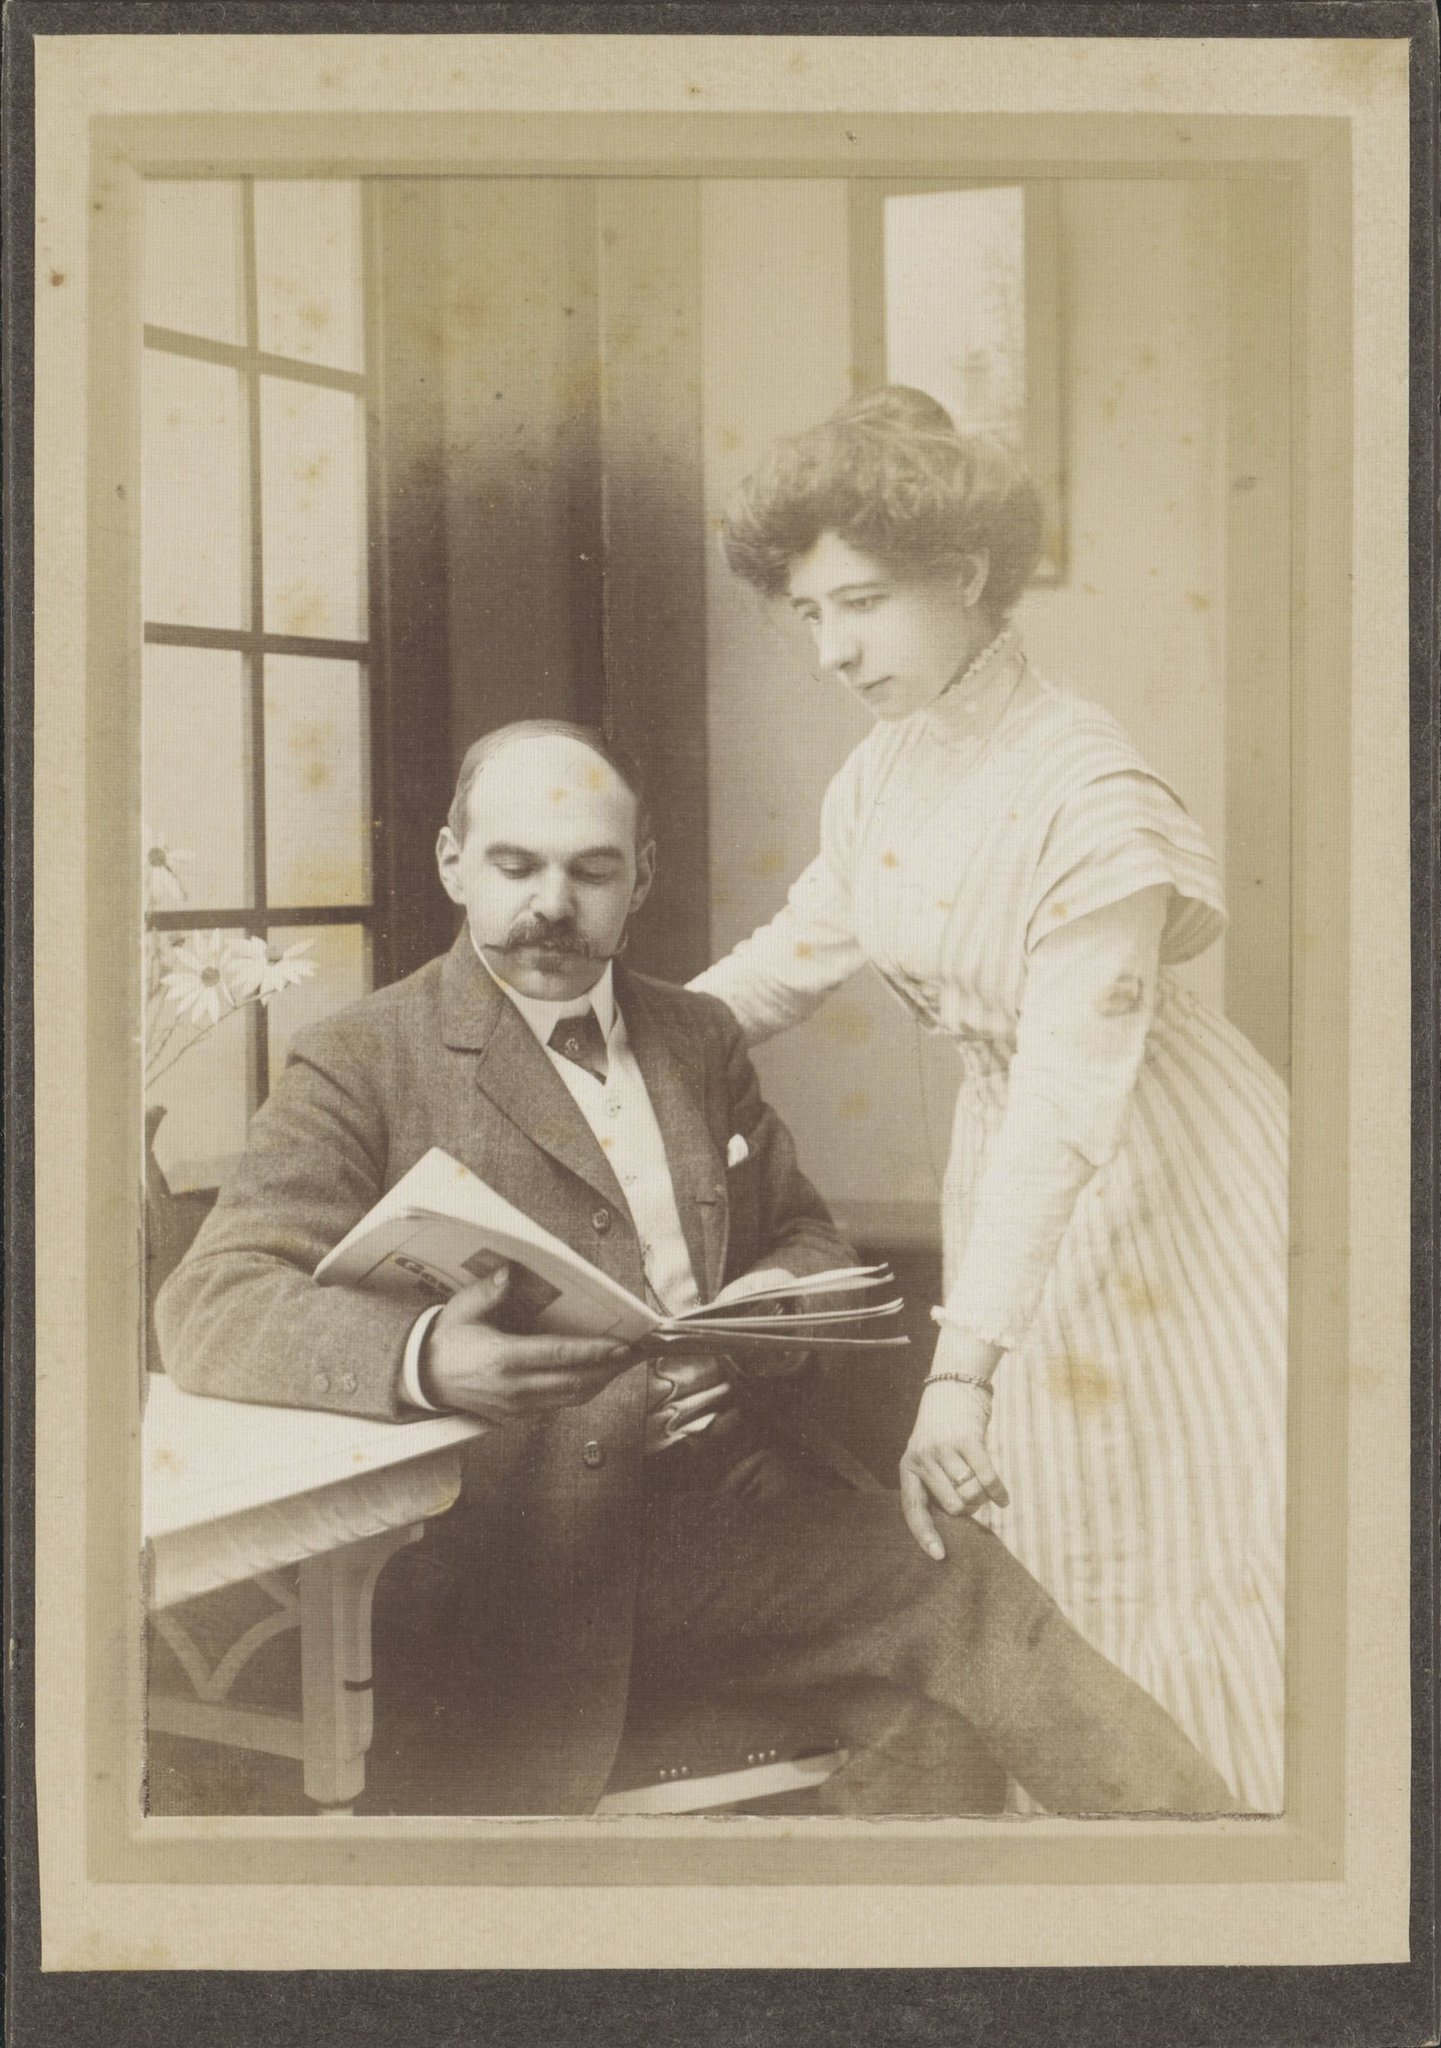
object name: photograph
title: Portret van een echtpaar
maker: peter jonkers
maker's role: sculptor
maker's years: 1864-1932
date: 1910-1920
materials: cardboard, linen, photographic support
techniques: gelatin silver print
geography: eindhoven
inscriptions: number: ‘14’, annotation: ‘Ter kennismaking met // mijn man!!!! // Marie’, address: ‘Fotografisch Atelier //P. Jonkers // Wilhelminaplein // Eindhoven // Ingang Wachtkamer // en // Atelier // Prins Hendrikstr. // Speciale inrichting // voor Vergrootingen’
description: Beeldhouwer en fotograaf Peter (Piet) Jonkers, lezend in een tijdschrift. Staand naast hem zijn vrouw Maria (Marie) Hubertina Jonkers-Tummers.